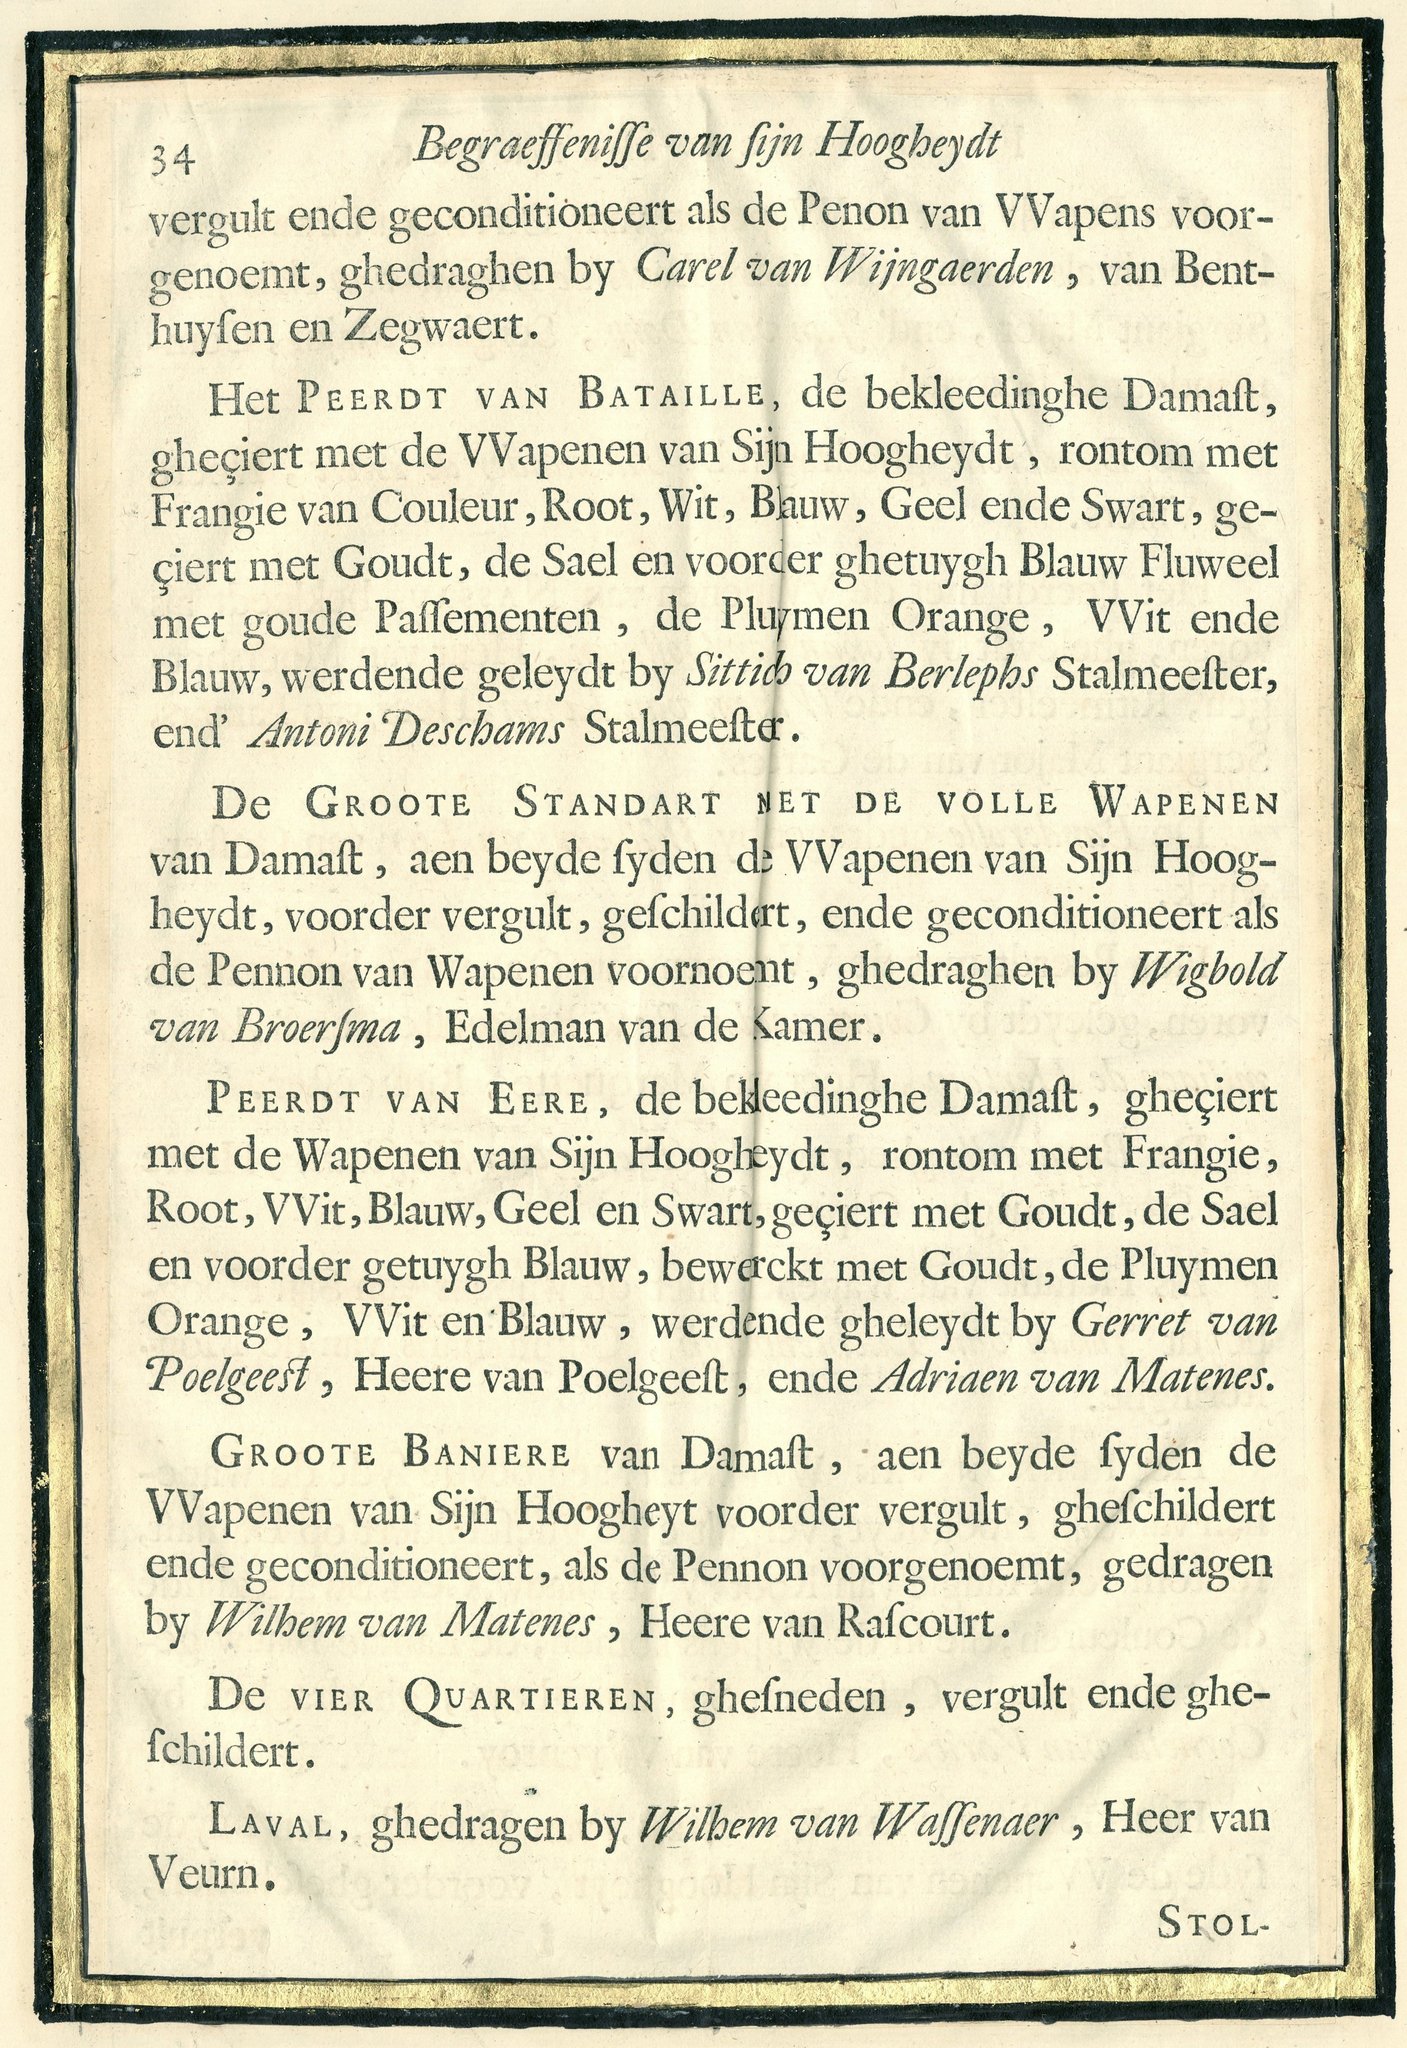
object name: book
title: Begraeffenisse van syne hoogheyt Frederick Henrick. Luxe ingekleurde uitgave van de prenten van de begrafenisstoet van Frederik Hendrik in 1647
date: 1651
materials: paint, paper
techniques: letterpress printing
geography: amsterdam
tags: delft, frederick henry (prince of orange)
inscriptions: date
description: Pagina 34 van de beschrijving van de begrafenis van Frederik Hendrik. Blad uitgeknipt, versierd met goud en ingeplakt in de luxe editie uit ca. 1755 van het boek 'Begraeffenisse van syne hoogheyt Frederick Henrick' van Pieter Post, uitgegeven te Amsterdam in 1651.